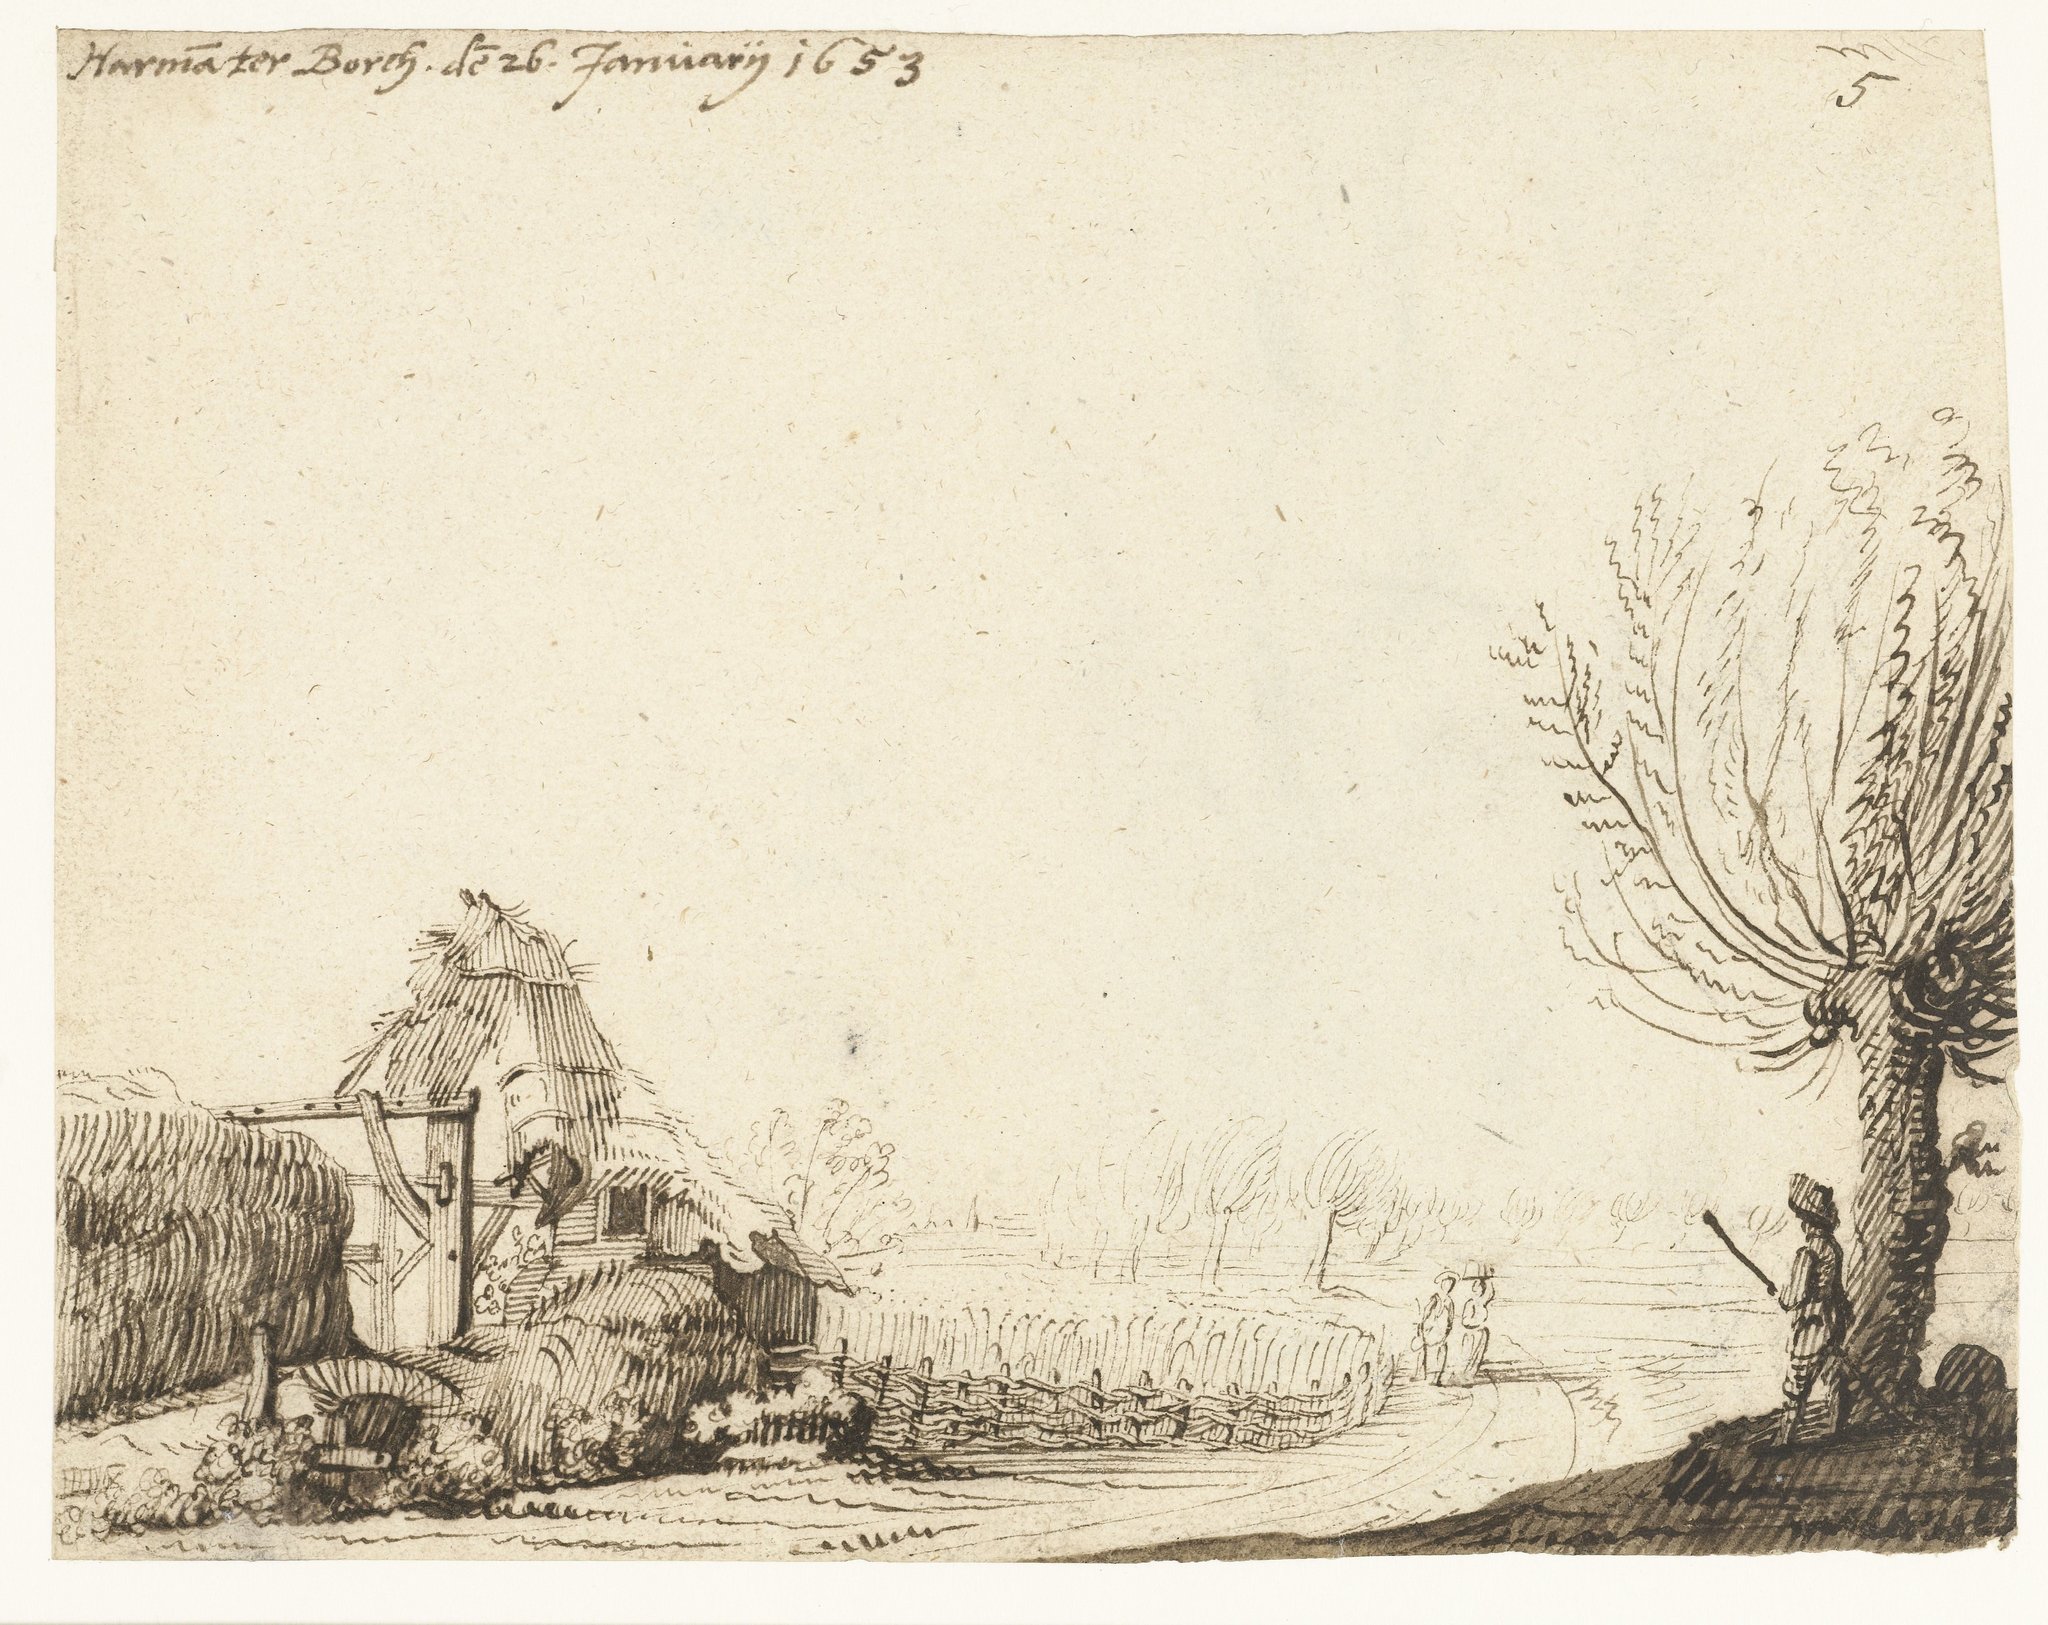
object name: drawing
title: Landschap met vervallen gebouw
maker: harmen ter borch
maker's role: draughtsman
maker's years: 1638-1677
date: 1653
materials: chalk, ink, paper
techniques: brush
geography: zwolle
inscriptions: annotation: ‘Harma[n] ter Borch. de[n] 26.Januarij 1653’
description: Kopie naar vervallen boerderij van Gerard de Jonge (RP-T-1887-A-1235).